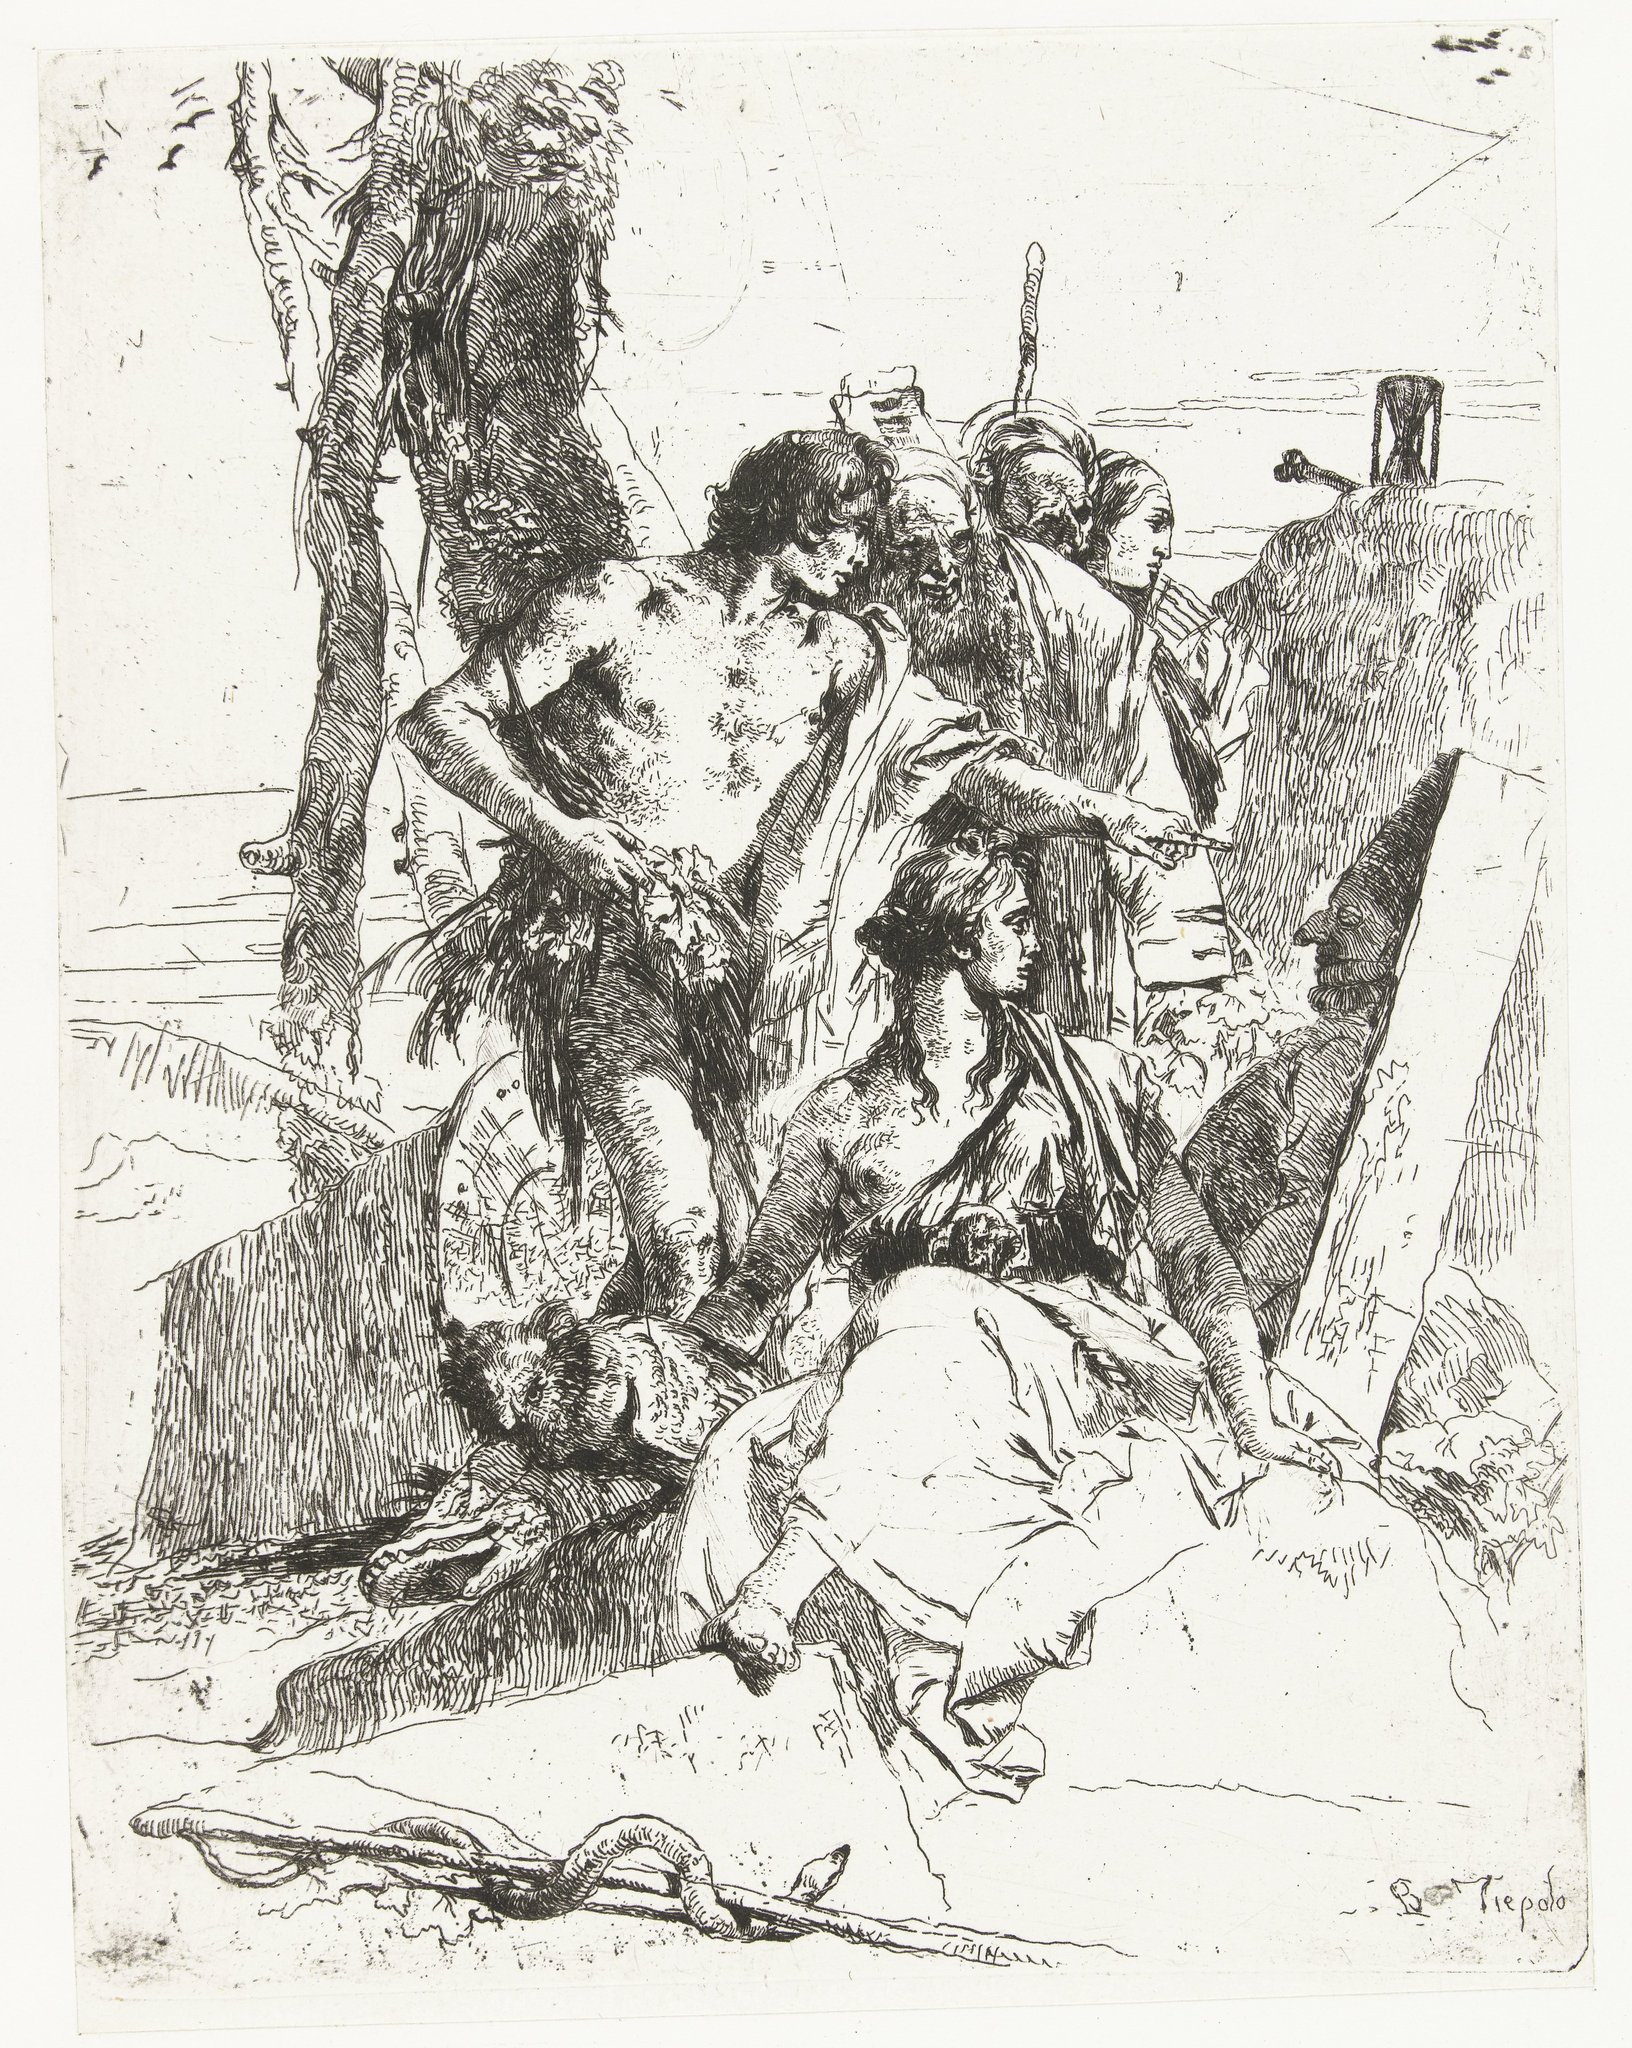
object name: print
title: The Discovery of Pulcinella’s Grave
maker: giovanni battista tiepolo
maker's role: draughtsman, painter, print maker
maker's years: 1696-1770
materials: paper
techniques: etching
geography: italy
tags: sorcerer, magician, wizard, warlock, types in 'commedia dell'arte': pulcinella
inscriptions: collector's mark: Lugt 2228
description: How can Pulcinella’s grave be discovered? After all, Pulcinella is a stock character in the commedia dell’ arte, the improvised Italian theatre. As such he does not actually exist, yet he is nevertheless immortal. However, everything is possible in the world that sprang from Tiepolo’s mind, and so he lies buried here (right foreground). The bone and hourglass emphasize that Pulcinella is also just a human, who has died.